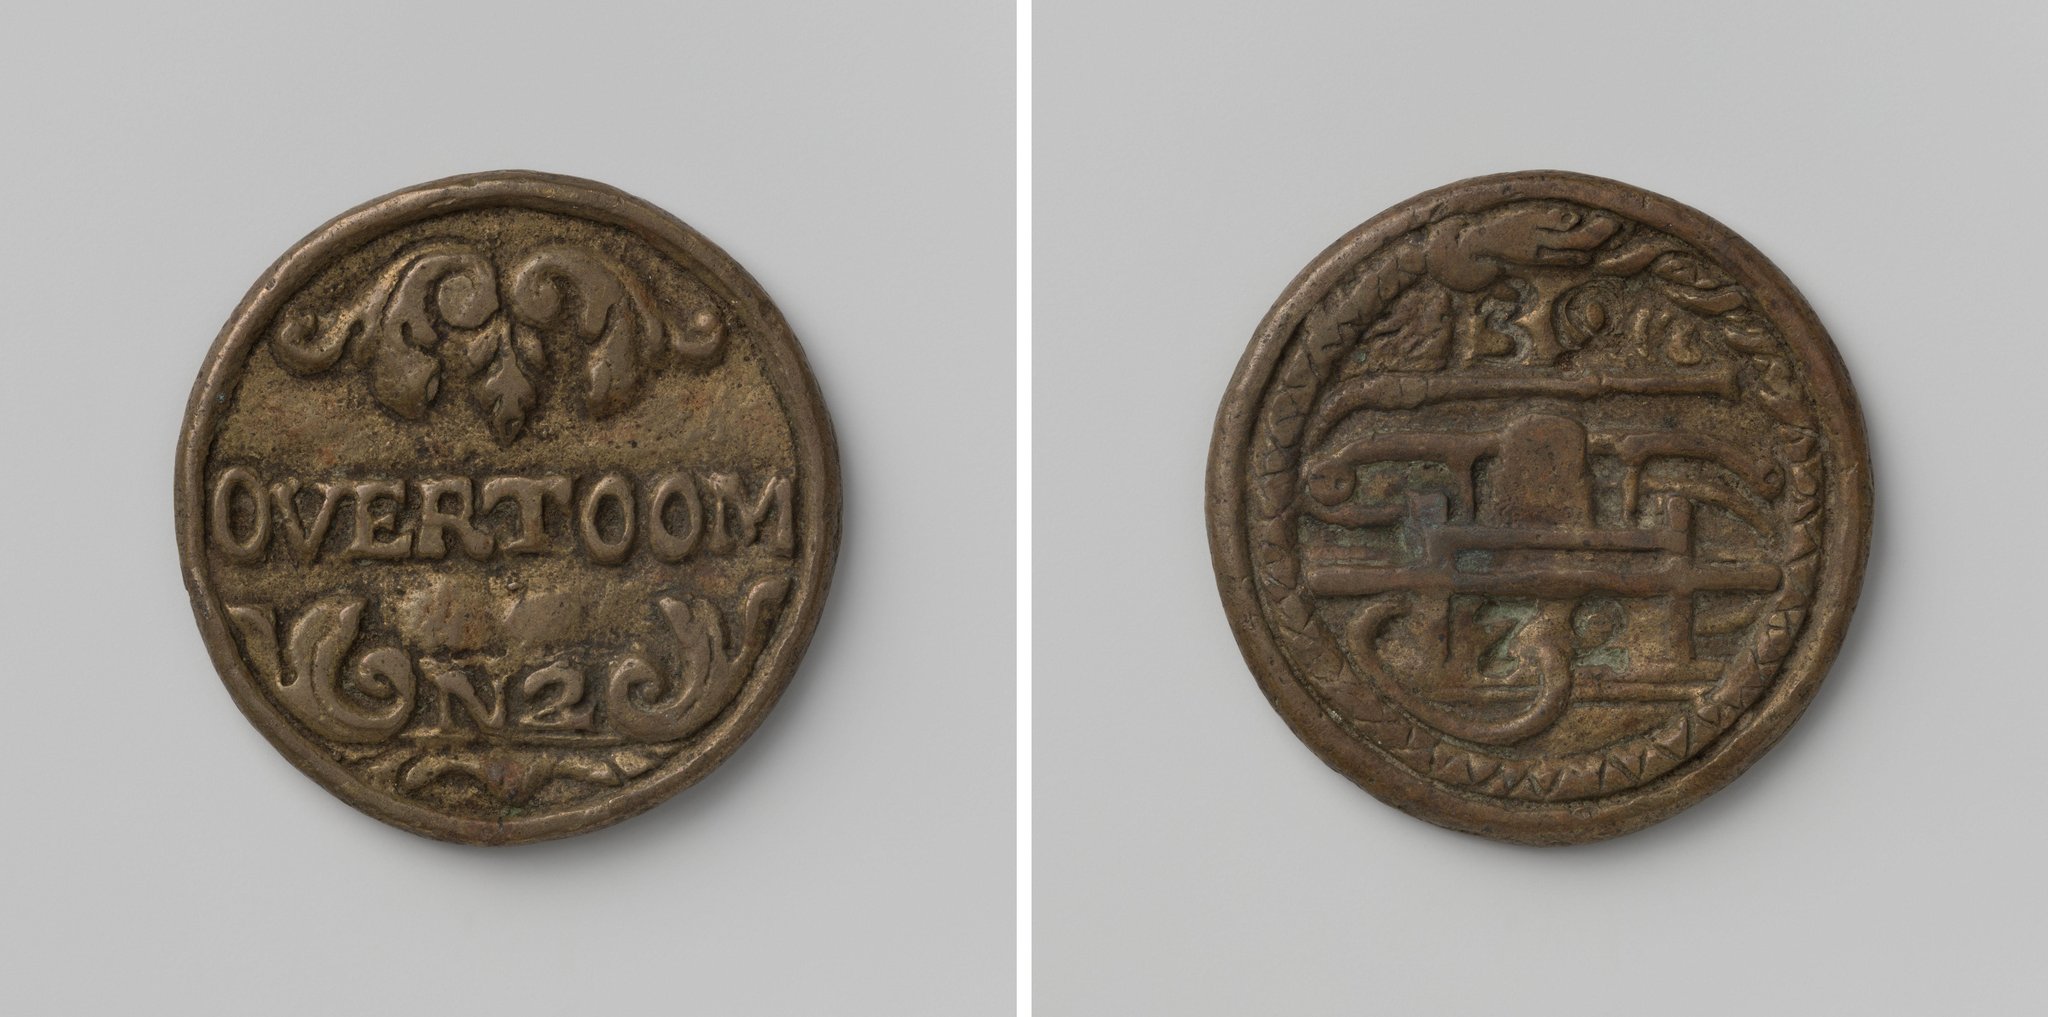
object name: fire engine medal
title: Overtoom, brandspuitpenning van wijk 2 met no. 32 en no. 22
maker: Anonymous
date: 1680-1800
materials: brass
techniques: casting, engraving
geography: amsterdam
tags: overtoom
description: Messing penning. Voorzijde: opschrift tussen bladerwerk boven cijfer N. 2. Keerzijde: brandspuit onder cartouche met no. 32 binnen slangerond; op zijde van brandspuit: cijfer 22